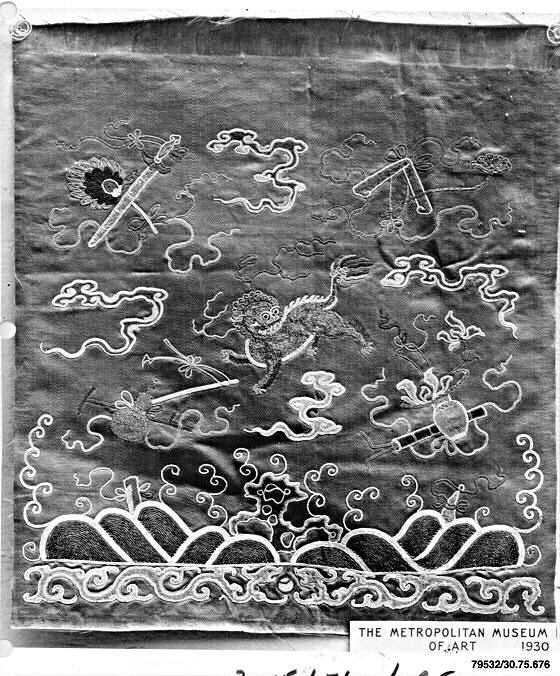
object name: square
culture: chinese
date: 1644-1911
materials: metal thread, silk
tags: mythical creatures